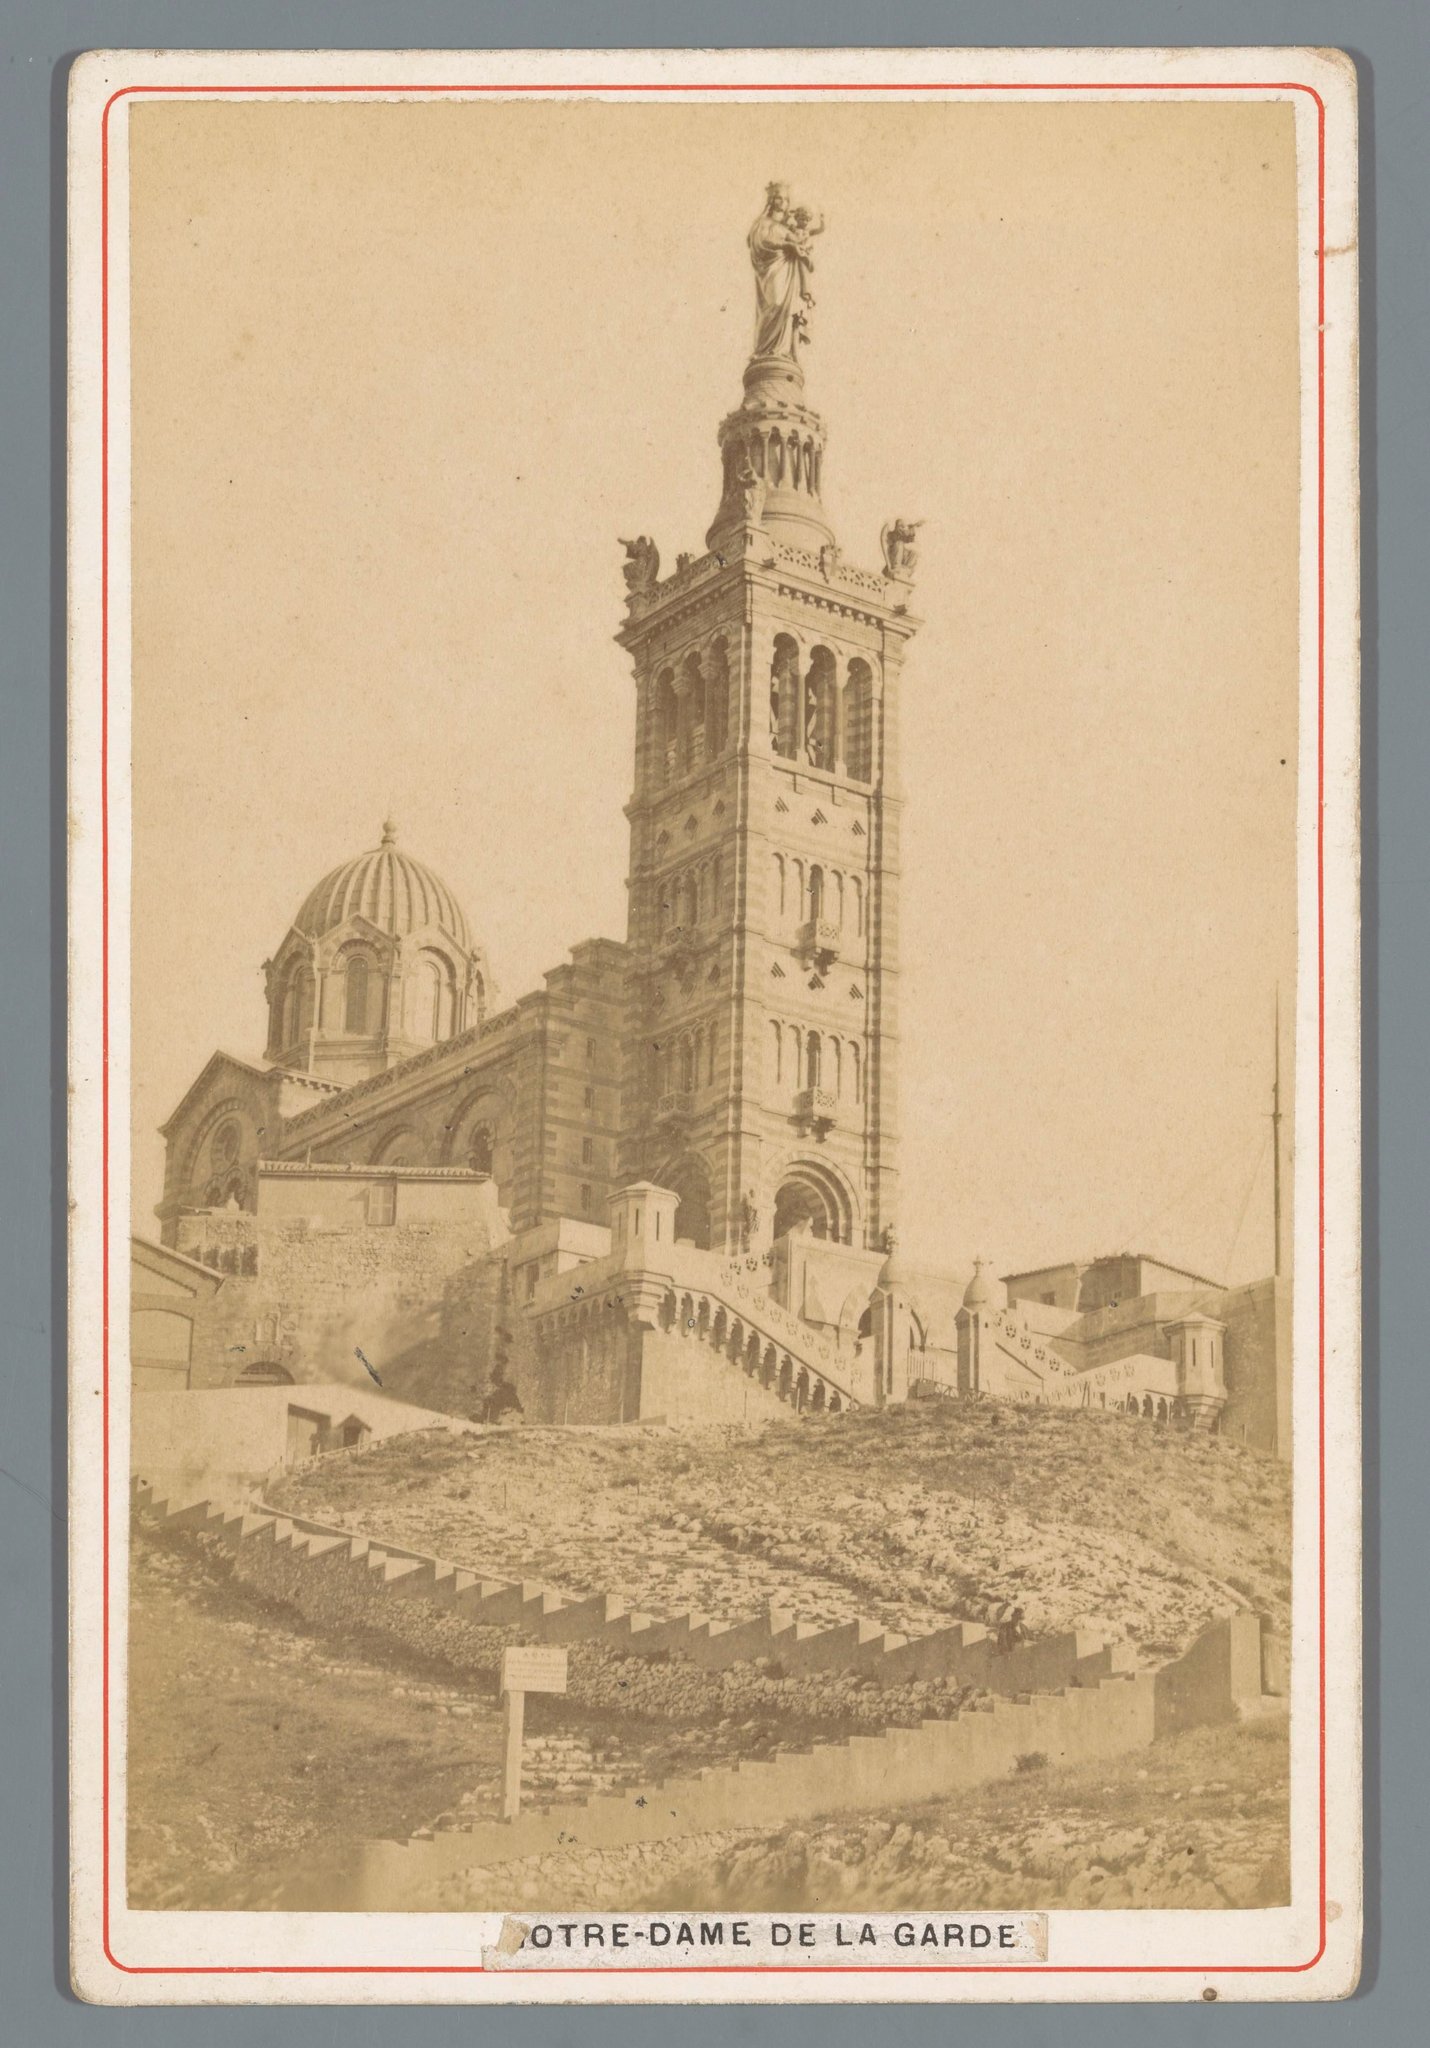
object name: photograph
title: Gezicht op de Notre-Dame de la Garde te Marseille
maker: Anonymous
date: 1850-1900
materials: cardboard, photographic support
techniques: albumen print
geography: marseille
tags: church (exterior)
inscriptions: inscription: ‘Notre-Dame de la Garde’